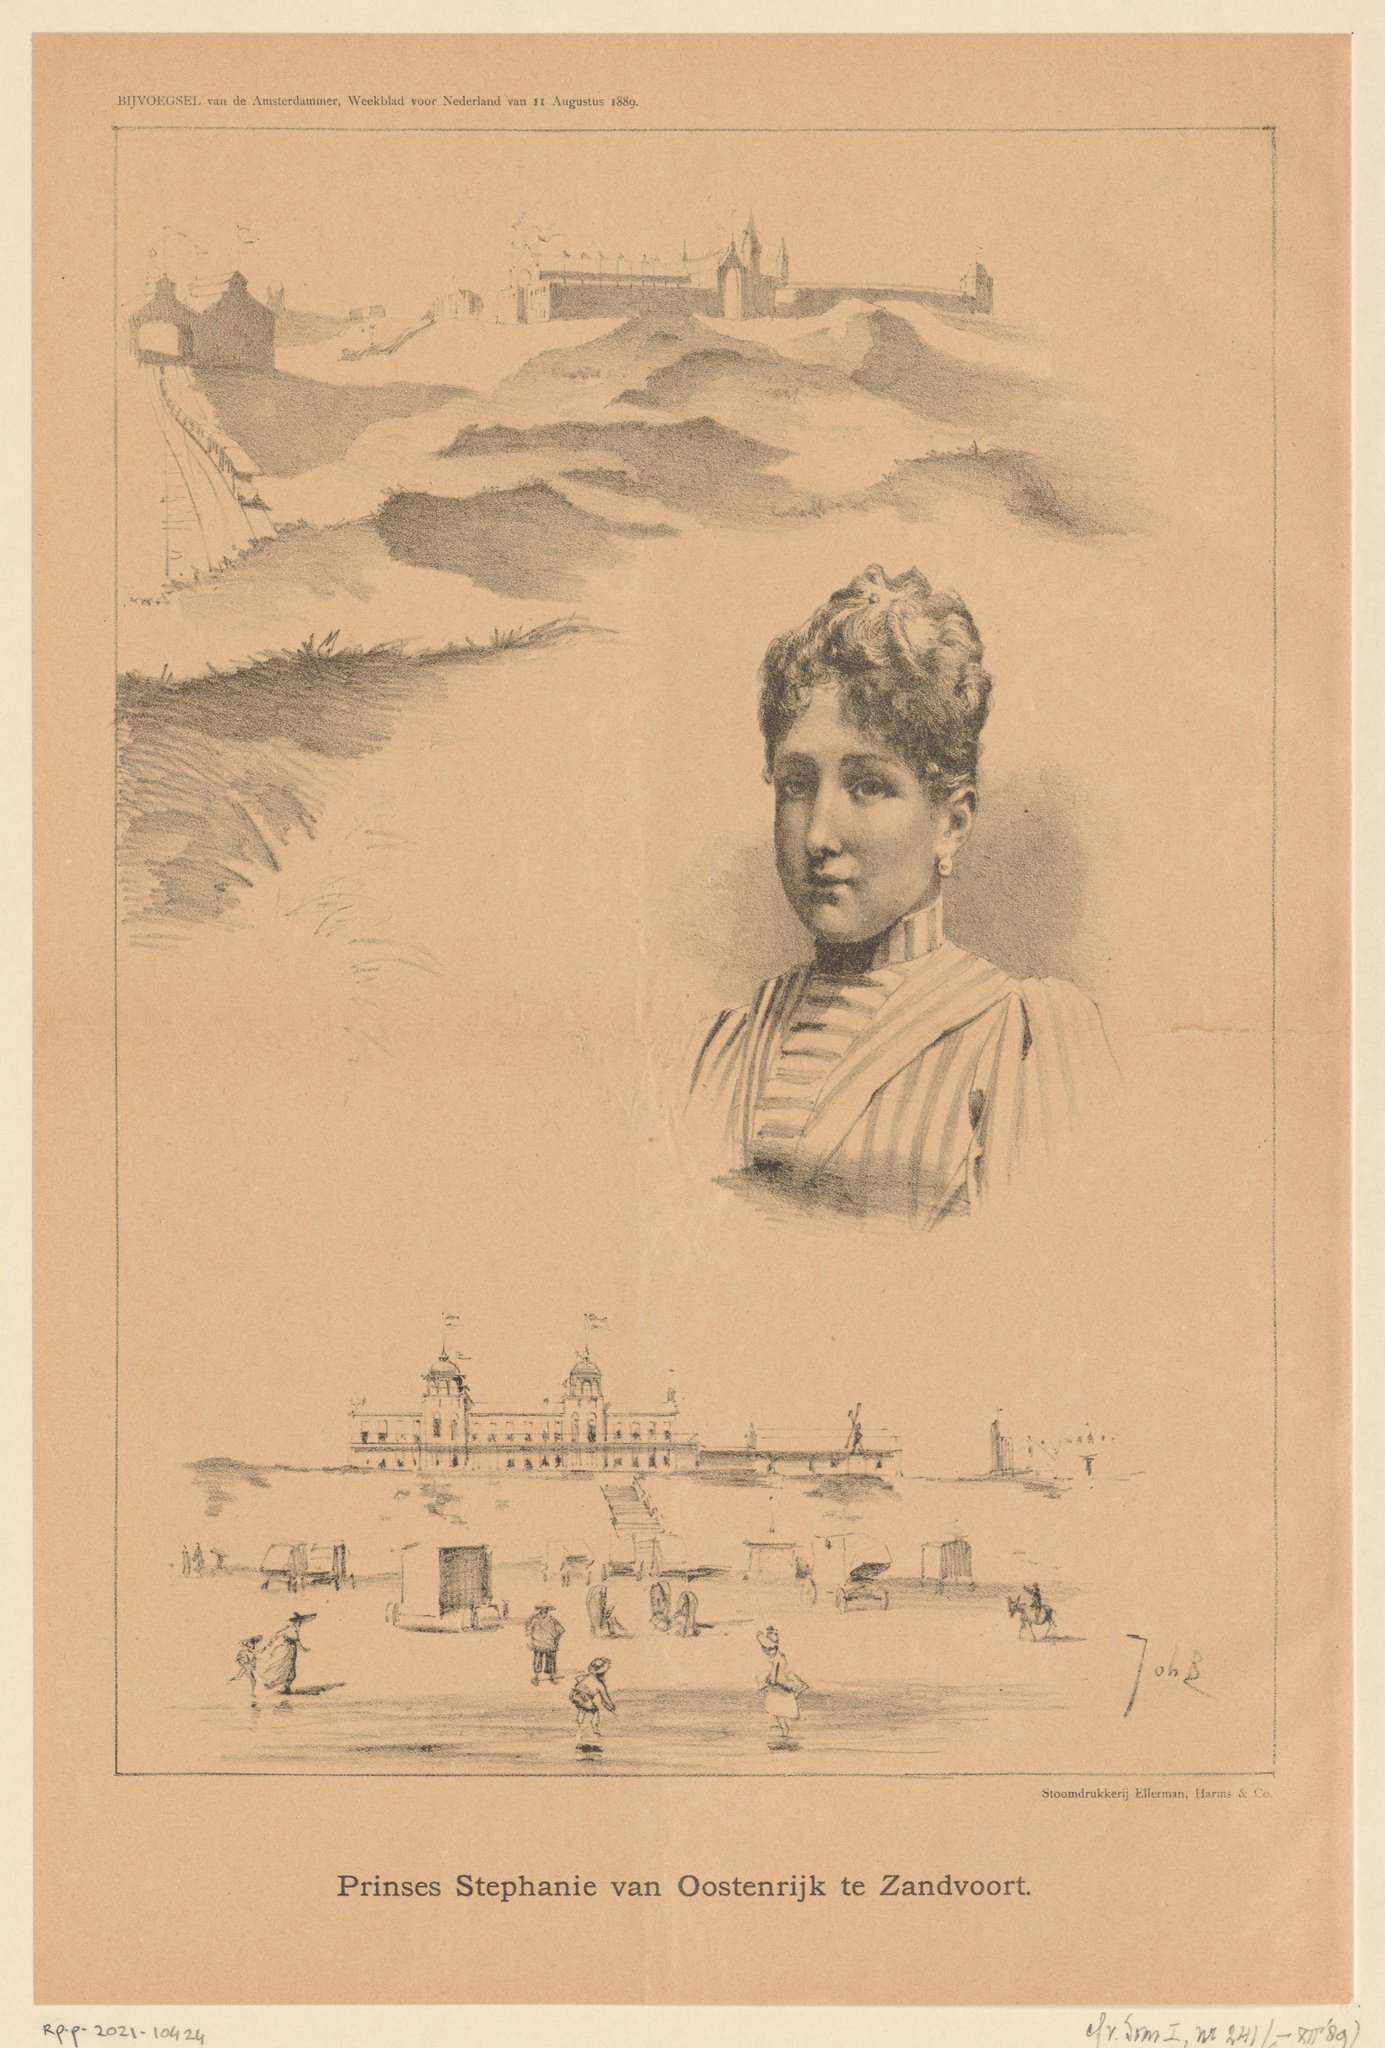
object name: print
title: Portret van Stefanie van België en twee gezichten op Zandfoort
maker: johan braakensiek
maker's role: draughtsman, print maker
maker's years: 1858-1940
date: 1889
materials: paper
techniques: lithograph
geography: amsterdam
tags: brussels, adult woman, historical persons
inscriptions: date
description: Prent uit het bijvoegsel van: De Amsterdammer. Weekblad voor Nederland, 11 augustus 1889.